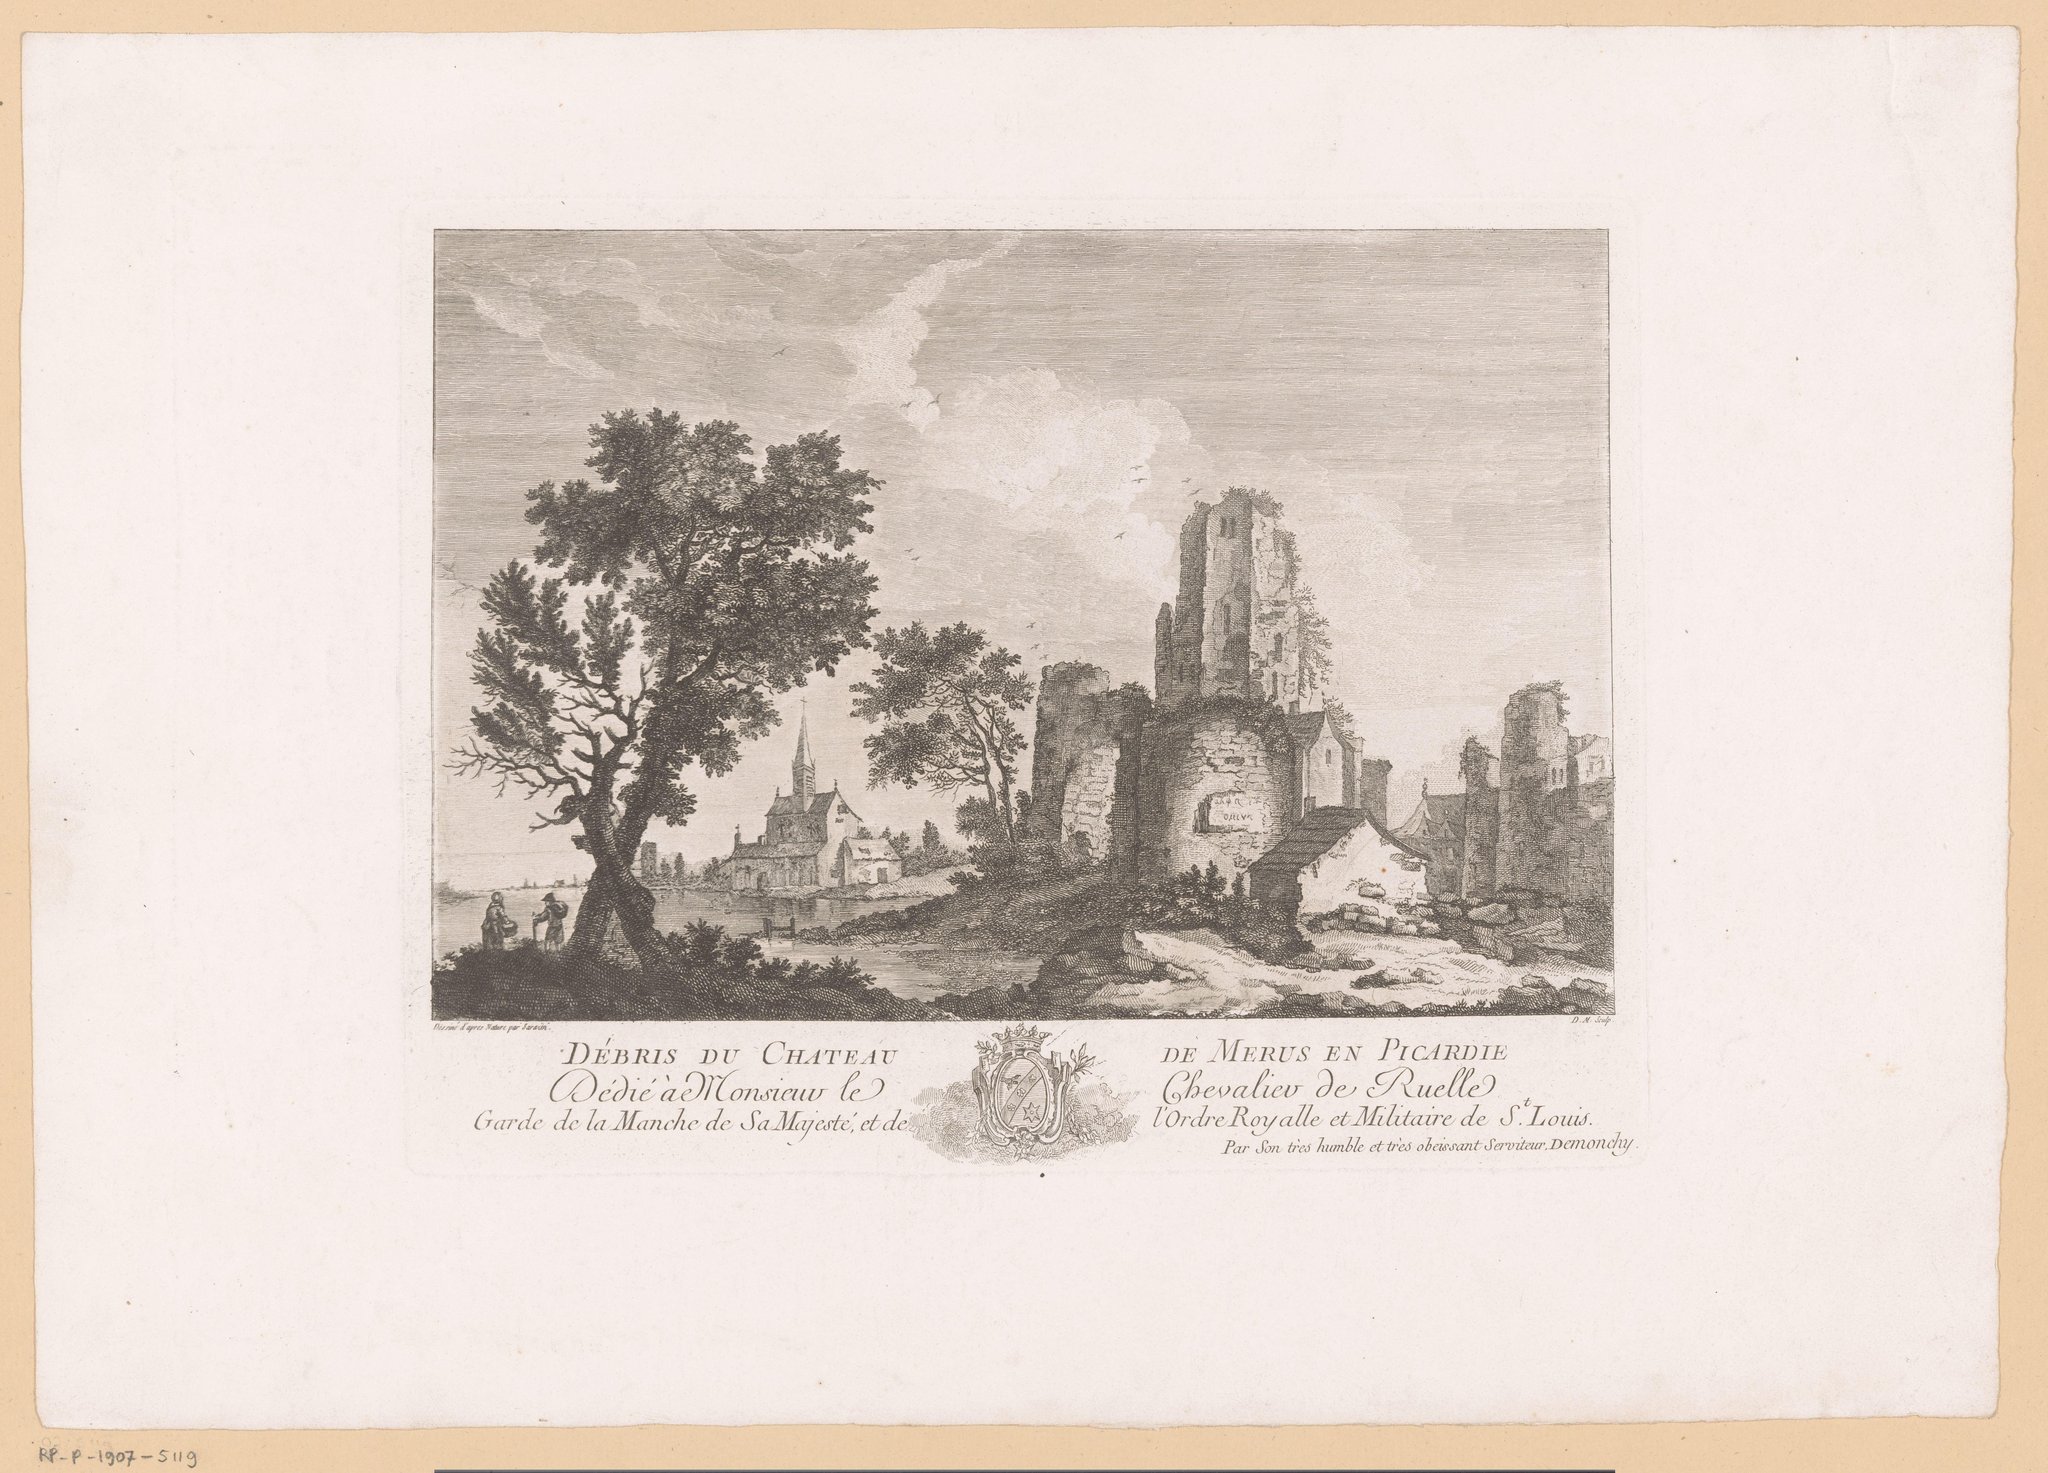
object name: print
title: Débris du Chateau de Merus en Picardie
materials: paper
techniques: etching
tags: ruin of a building ~ architecture, landscape with ruins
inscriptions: collector's mark: Lugt 2228